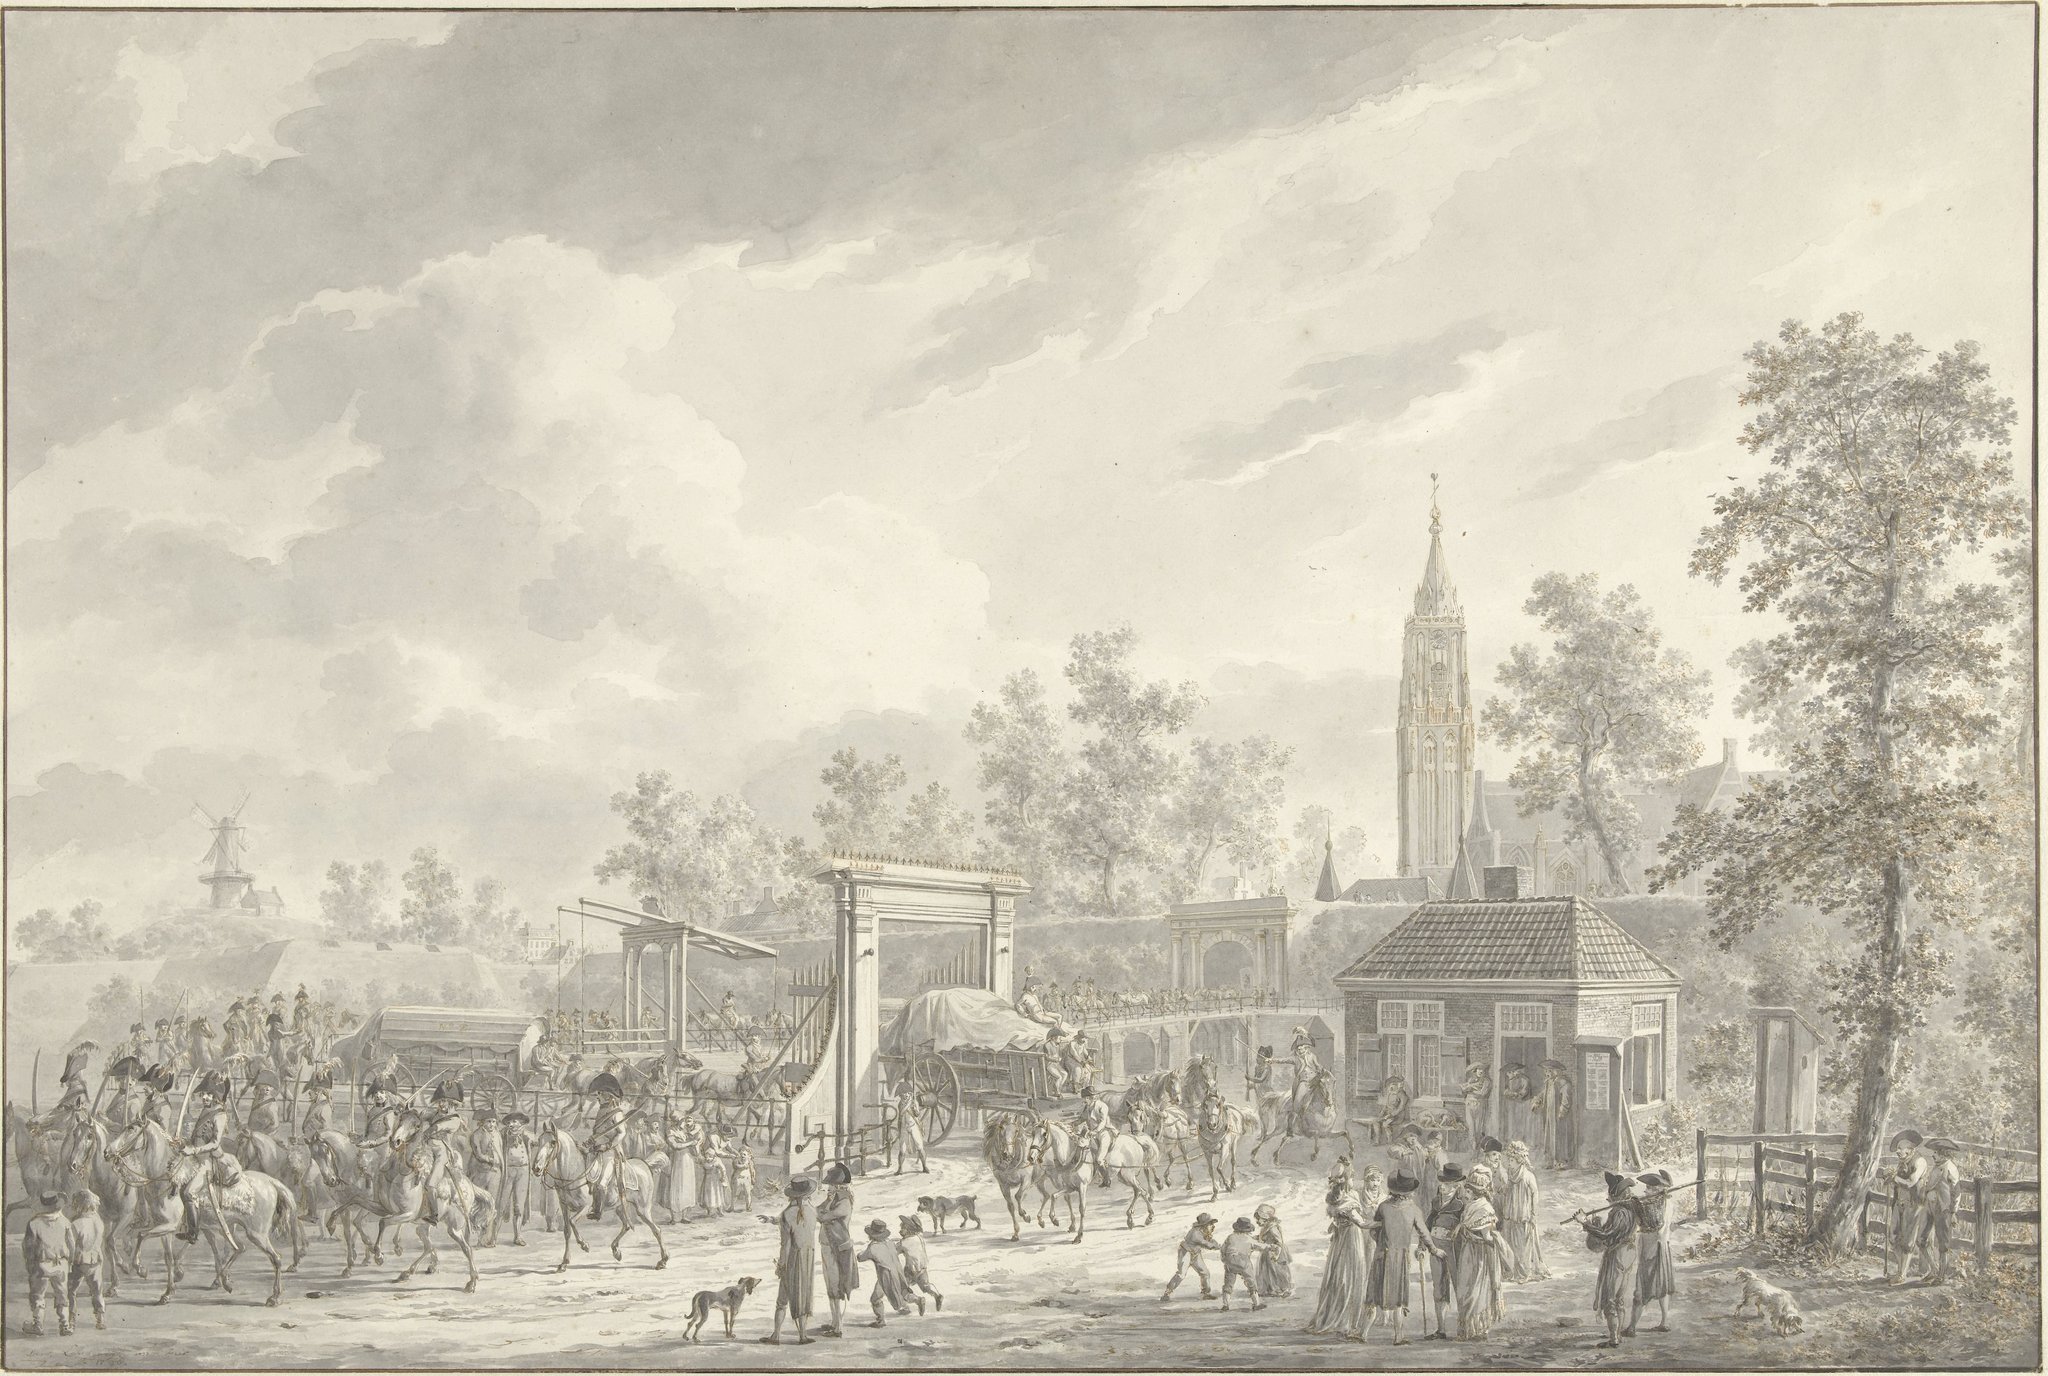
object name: drawing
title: Het vertrek van het garnizoen van Amersfoort in 1790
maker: dirk langendijk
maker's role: draughtsman, painter, print maker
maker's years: 1748-1805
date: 1790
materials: ink, paper, pencil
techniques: brush, pen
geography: northern netherlands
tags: marching away (troops)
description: Het vertrek van een garnizoen cavalerie uit Amersfoort in 1790. In een kolonne rijden de soldaten met wagens door een poort de stad uit.